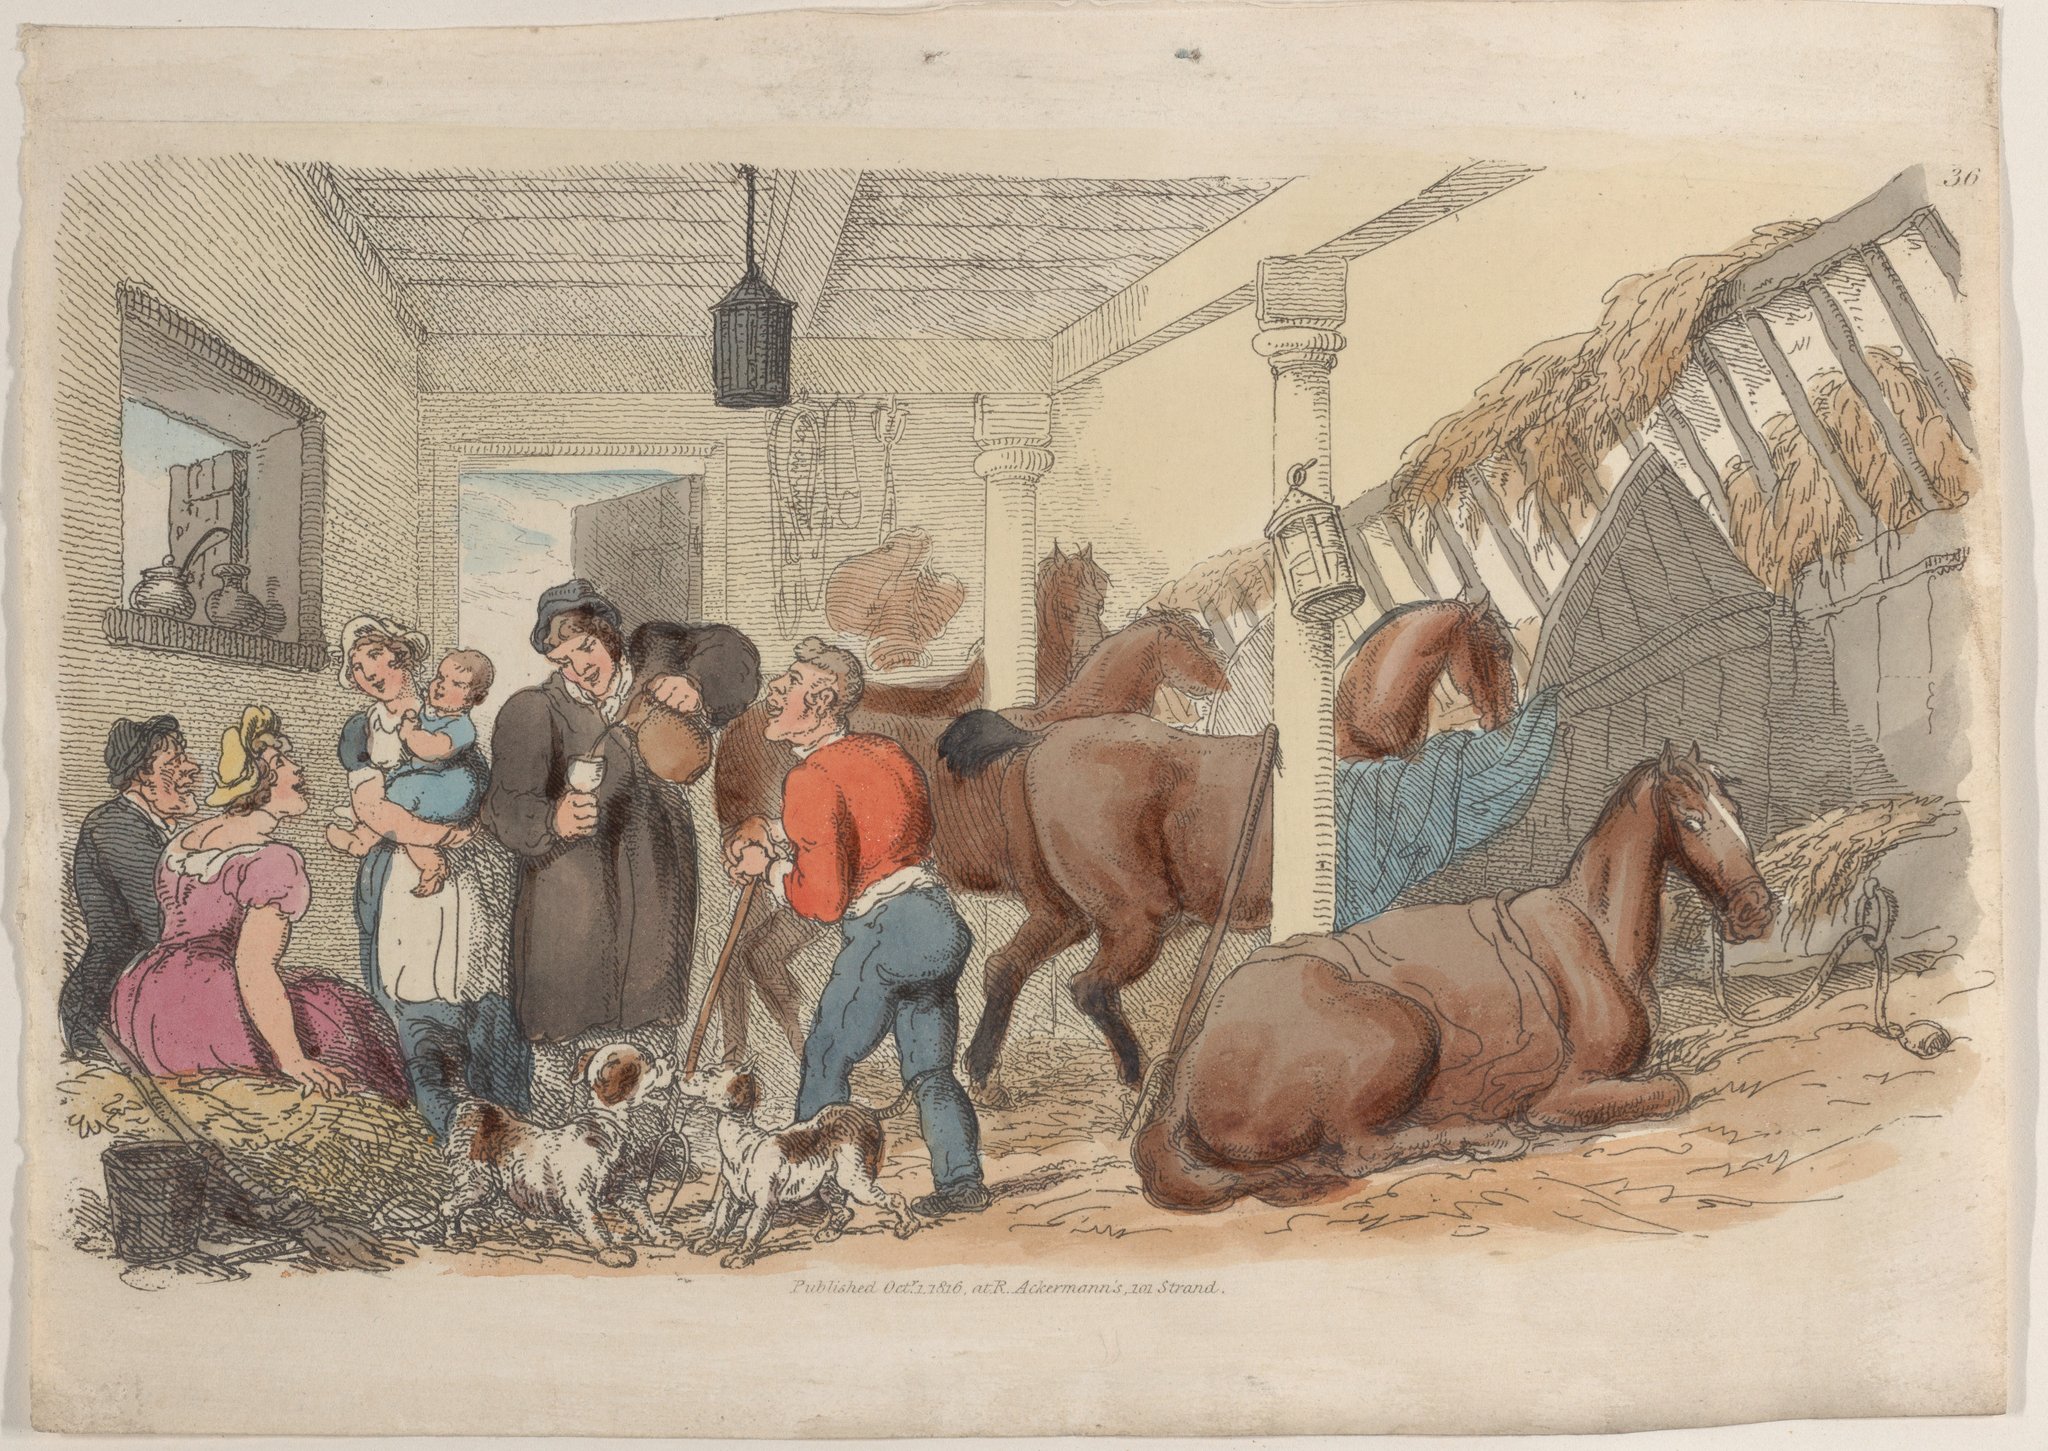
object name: print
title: Plate 36, from "World in Miniature"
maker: thomas rowlandson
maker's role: artist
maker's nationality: british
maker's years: 1757-1827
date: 1816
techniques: etching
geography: london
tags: men,women,dogs,horses